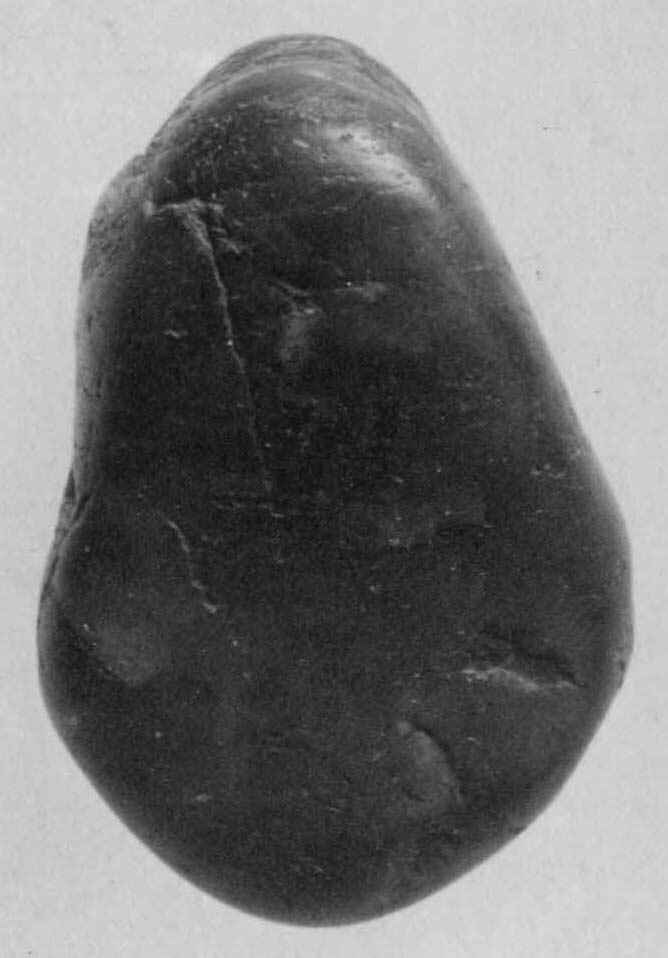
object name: fragment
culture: chinese or turkestani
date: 1902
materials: jade